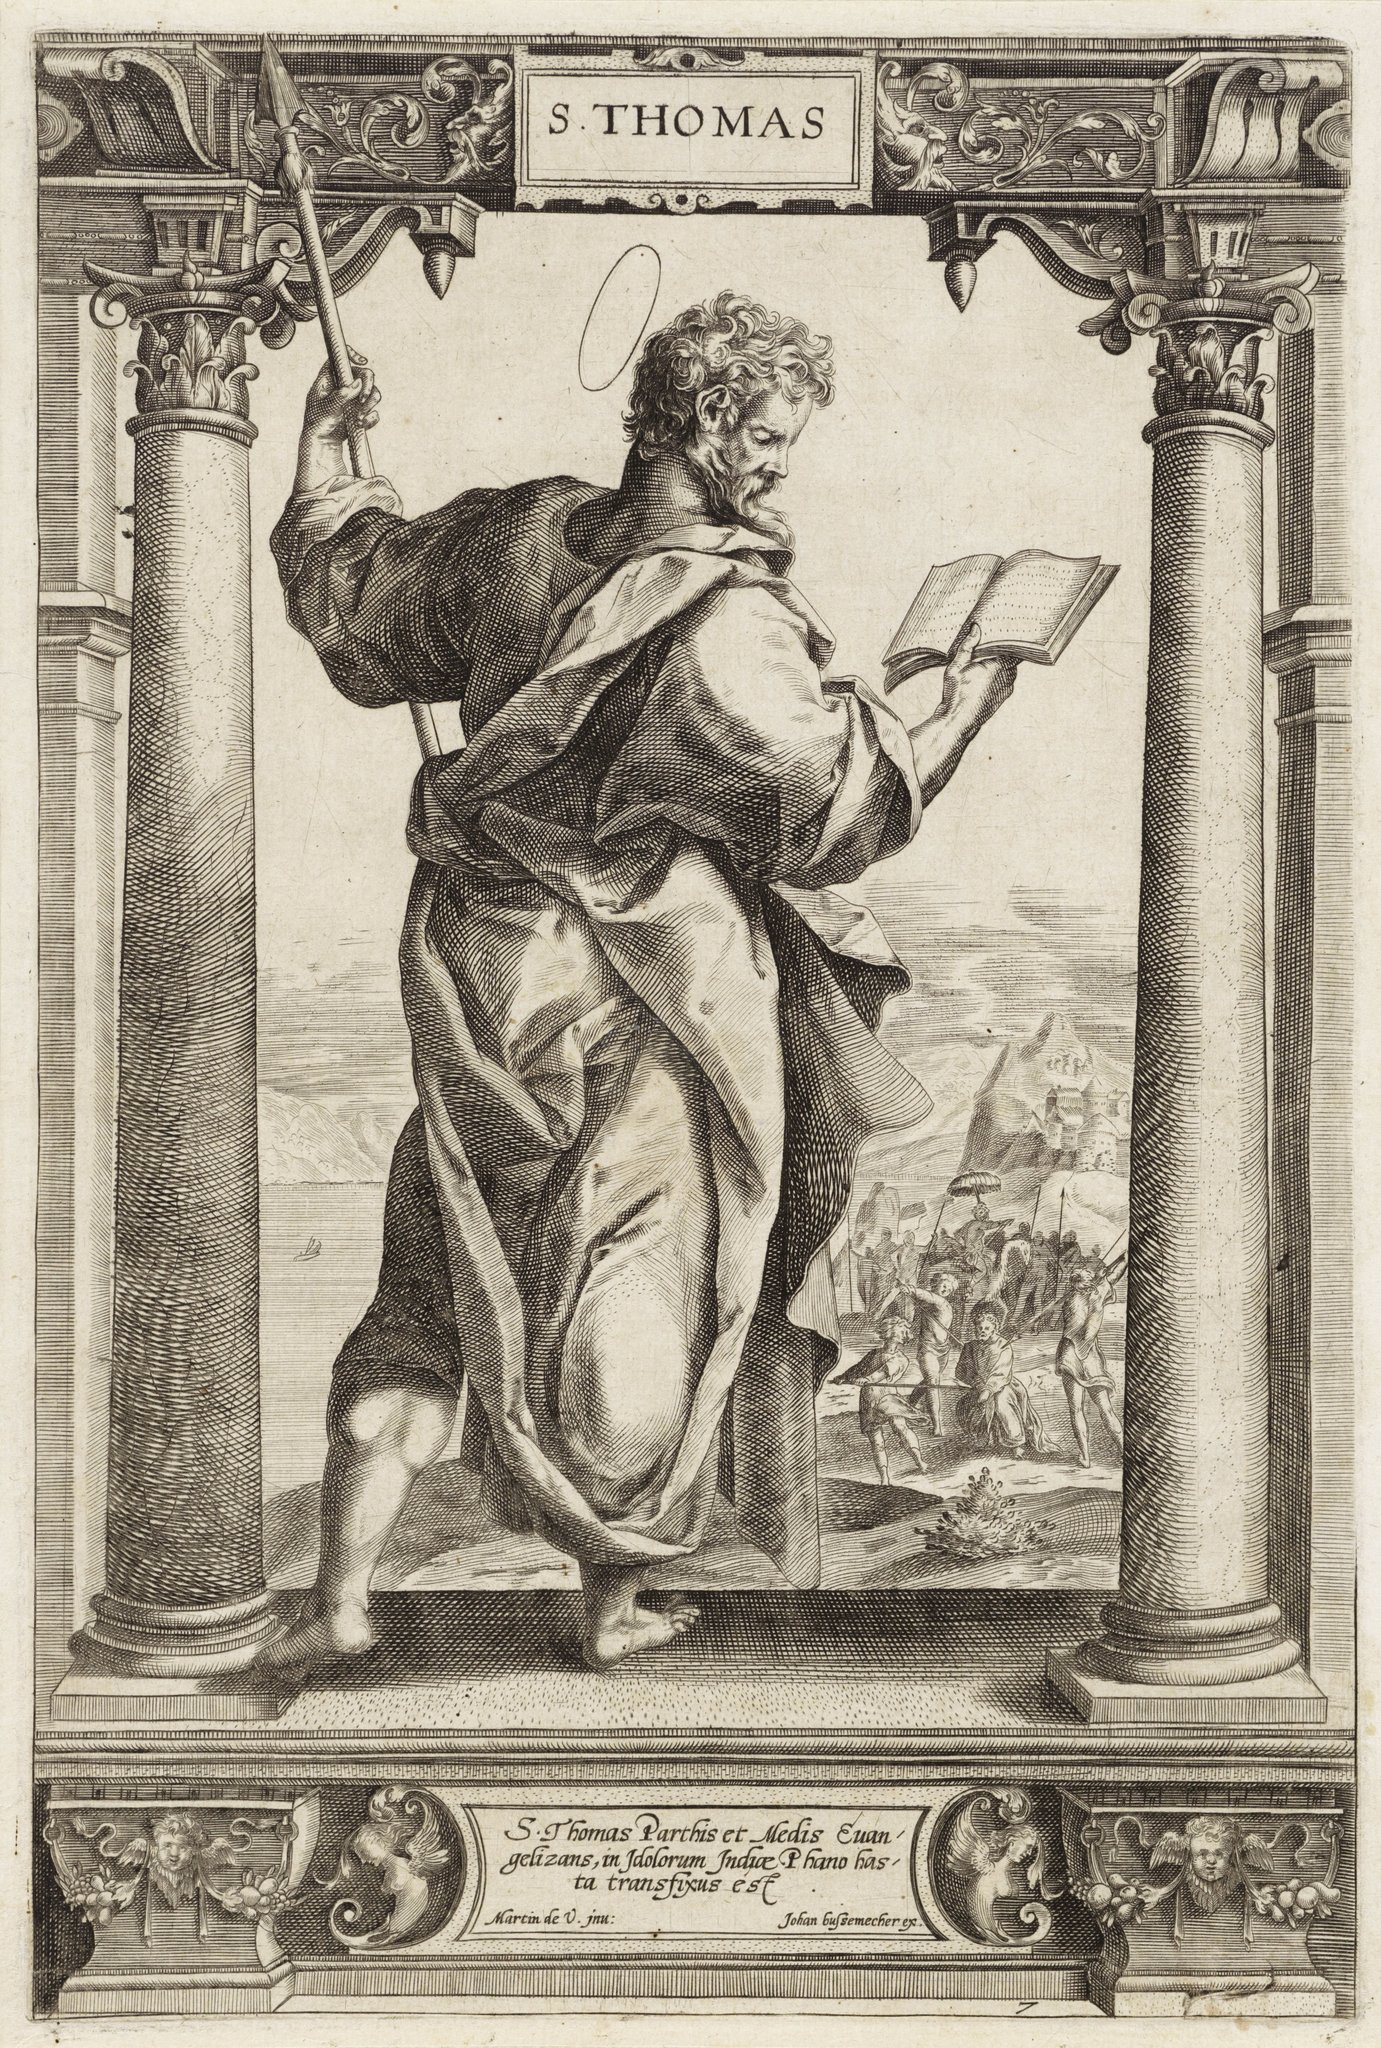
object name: print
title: S. Thomas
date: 1580-1613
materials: paper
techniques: engraving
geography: antwerp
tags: the apostle thomas; possible attributes: book, chalice, girdle, heart, lance or spear, scroll, square, stones, column, pillar ~ architecture, death of thomas: he is brought out of the city by four soldiers, who kill him with their lances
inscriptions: collector's mark: Lugt 240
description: De heilige Tomas staat, op de rug gezien, tussen twee zuilen in een architecturale omlijsting. In zijn ene hand houdt hij een opengeslagen boek, in zijn andere hand een speer. Op de achtergrond is te zien hoe soldaten hem met speren doodsteken. In het kader onderaan een drieregelig onderschrift in het Latijn.